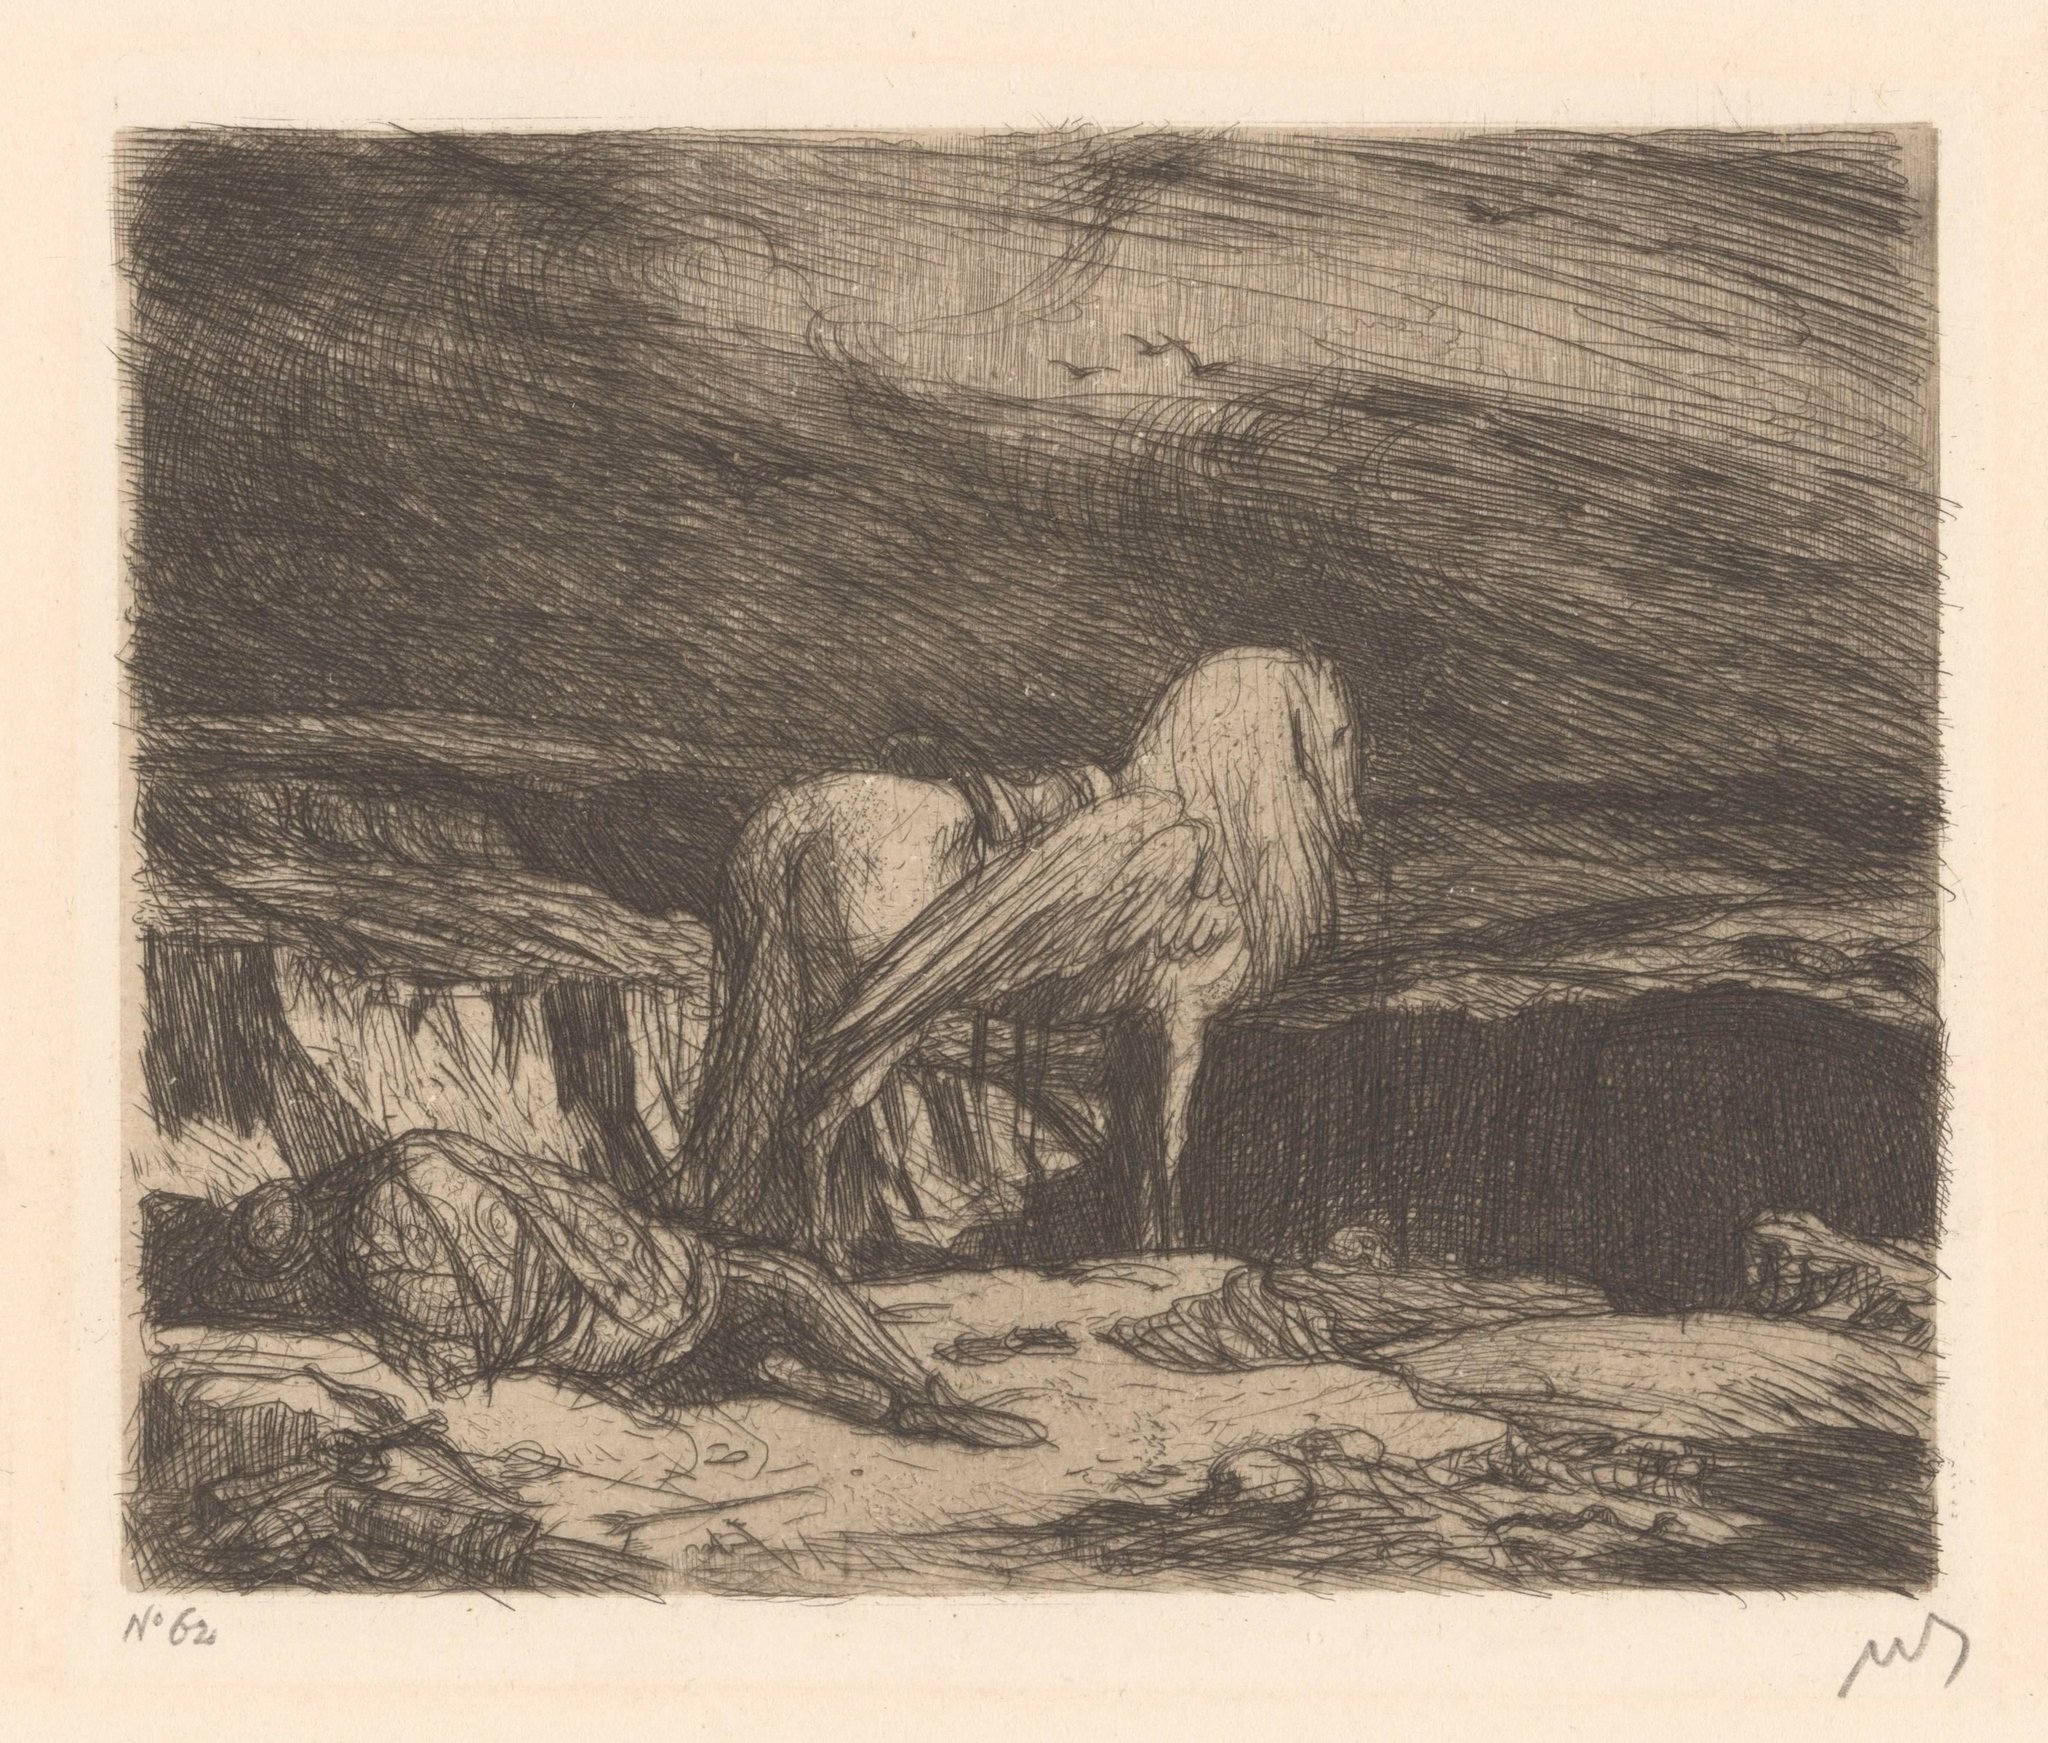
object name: print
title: Romance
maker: marius bauer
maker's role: draughtsman, print maker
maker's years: 1867-1932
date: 1897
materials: paper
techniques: etching, intaglio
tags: sleeping on the ground, fabulous animals ~ hoofed animals: winged horse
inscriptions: collector's mark: Lugt 2228, watermark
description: Bauer vervaardigde deze ets voor zijn prentenserie naar het Roemeense sprookje 'La jeunesse inaltérable et la vie éternelle', maar nam de ets er uiteindelijk niet in op.